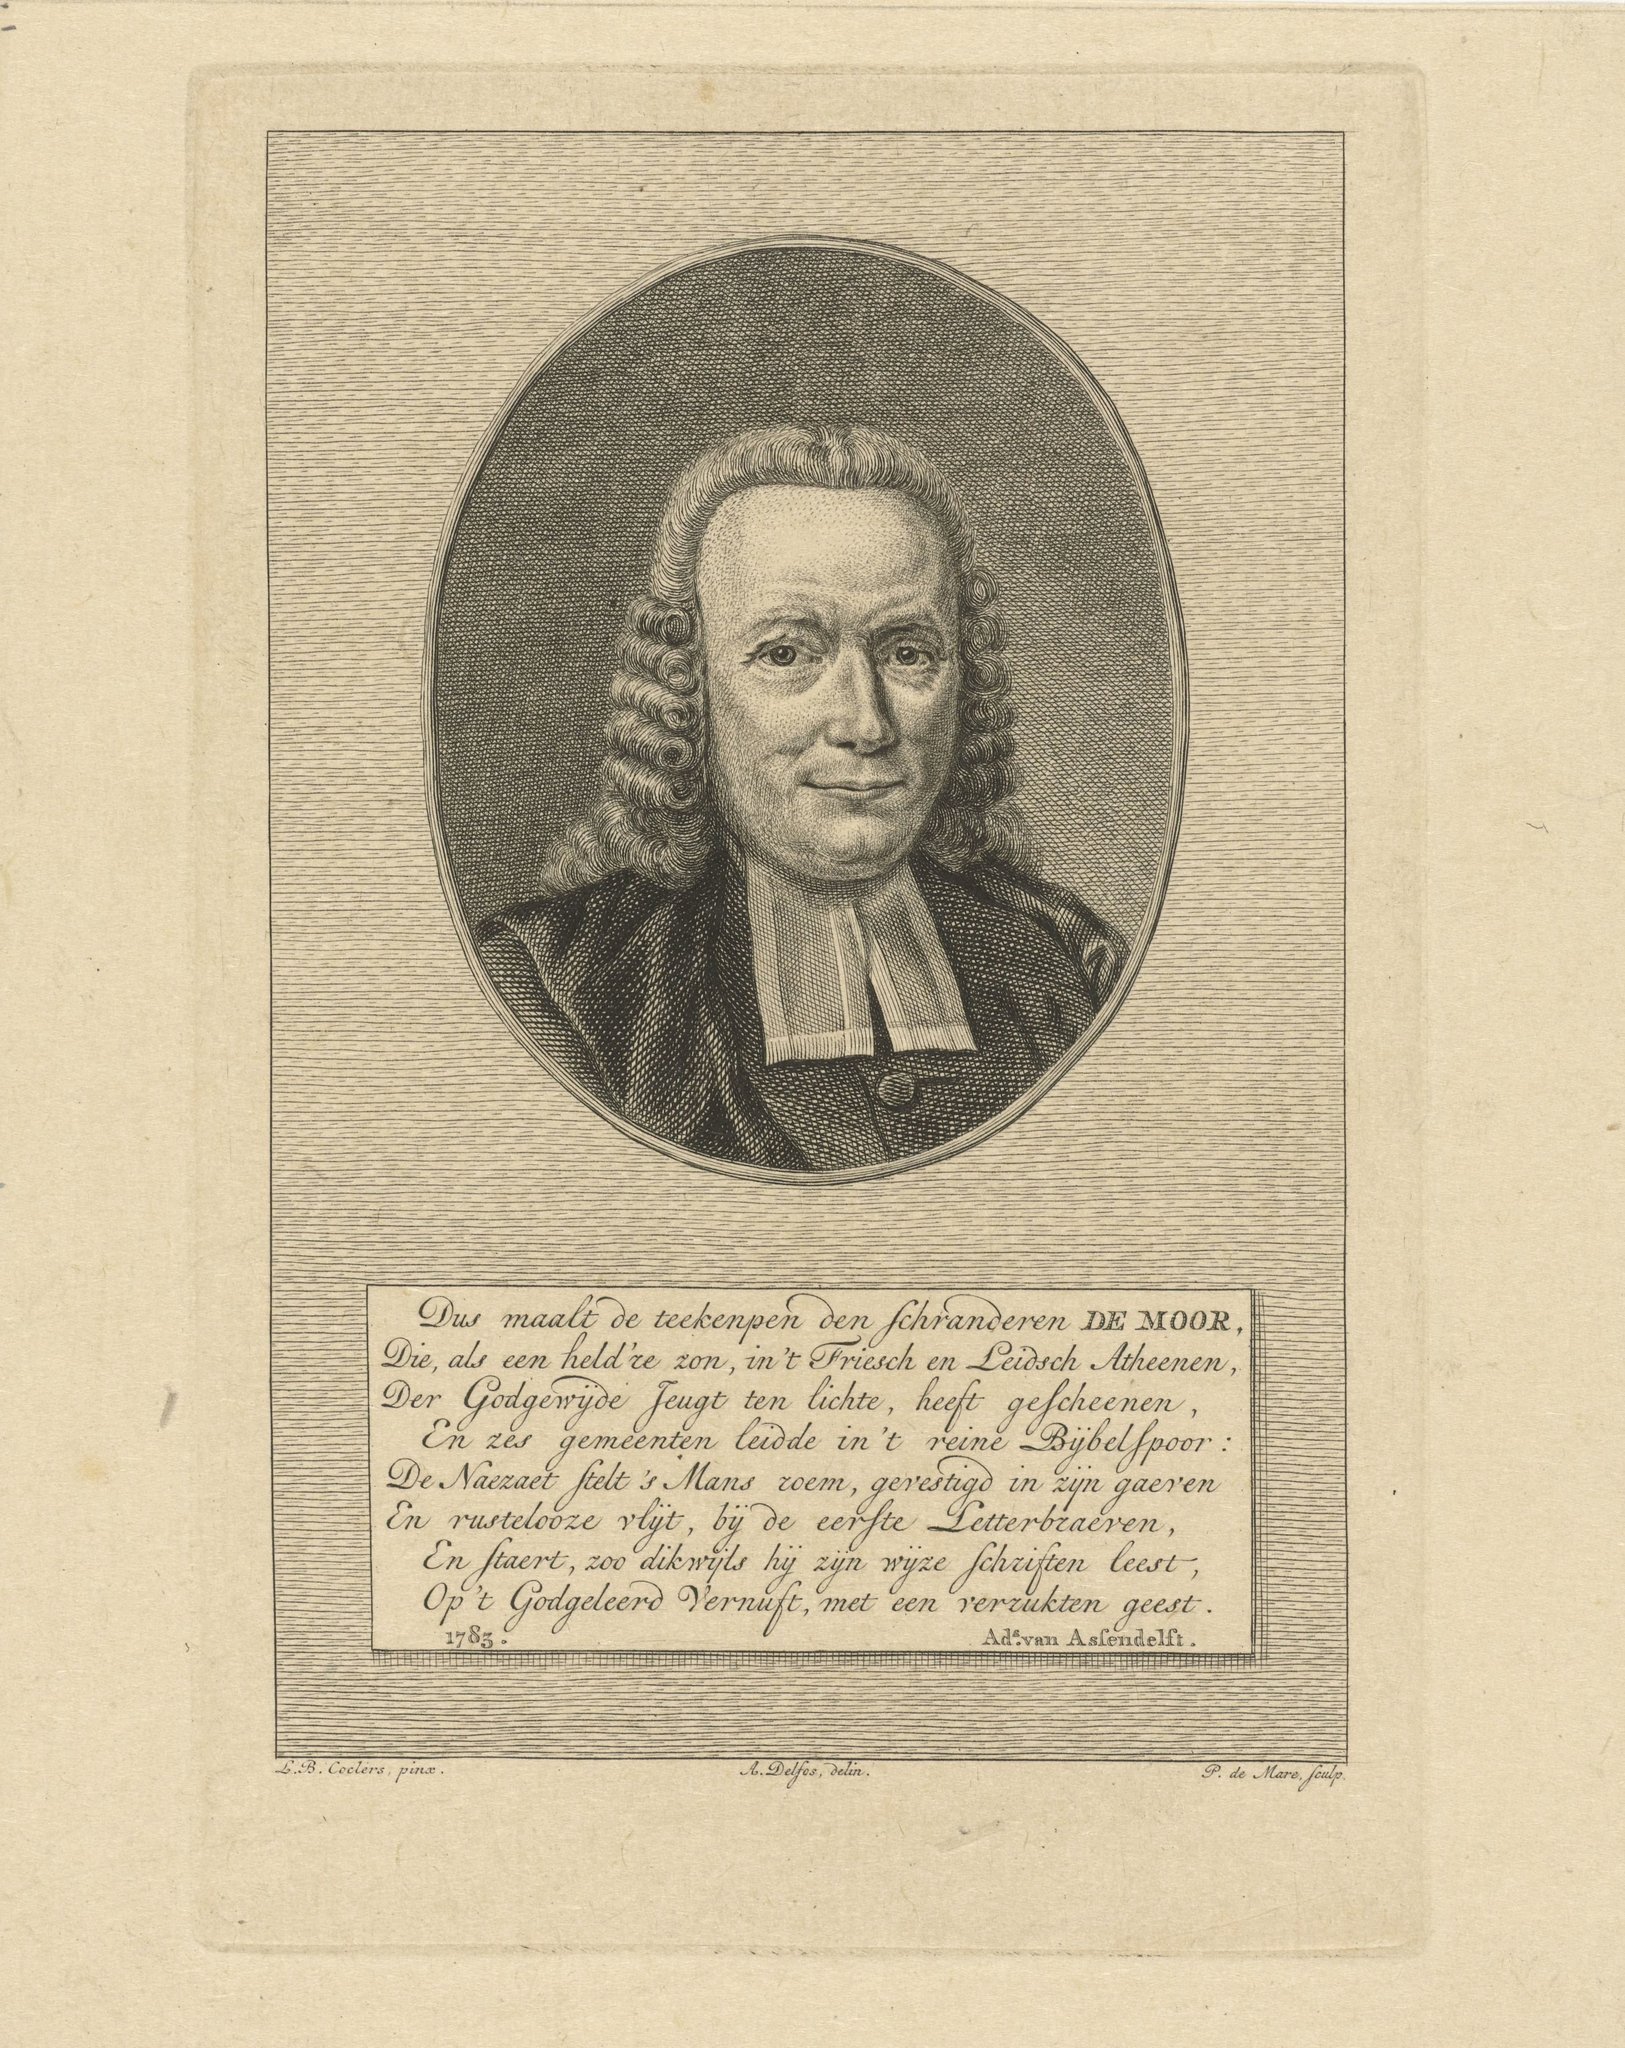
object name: print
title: Portret van Bernard de Moor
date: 1783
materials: paper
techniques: engraving, etching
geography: leiden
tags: gouda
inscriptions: collector's mark: Lugt 240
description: Portret van de predikant Bernard de Moor.